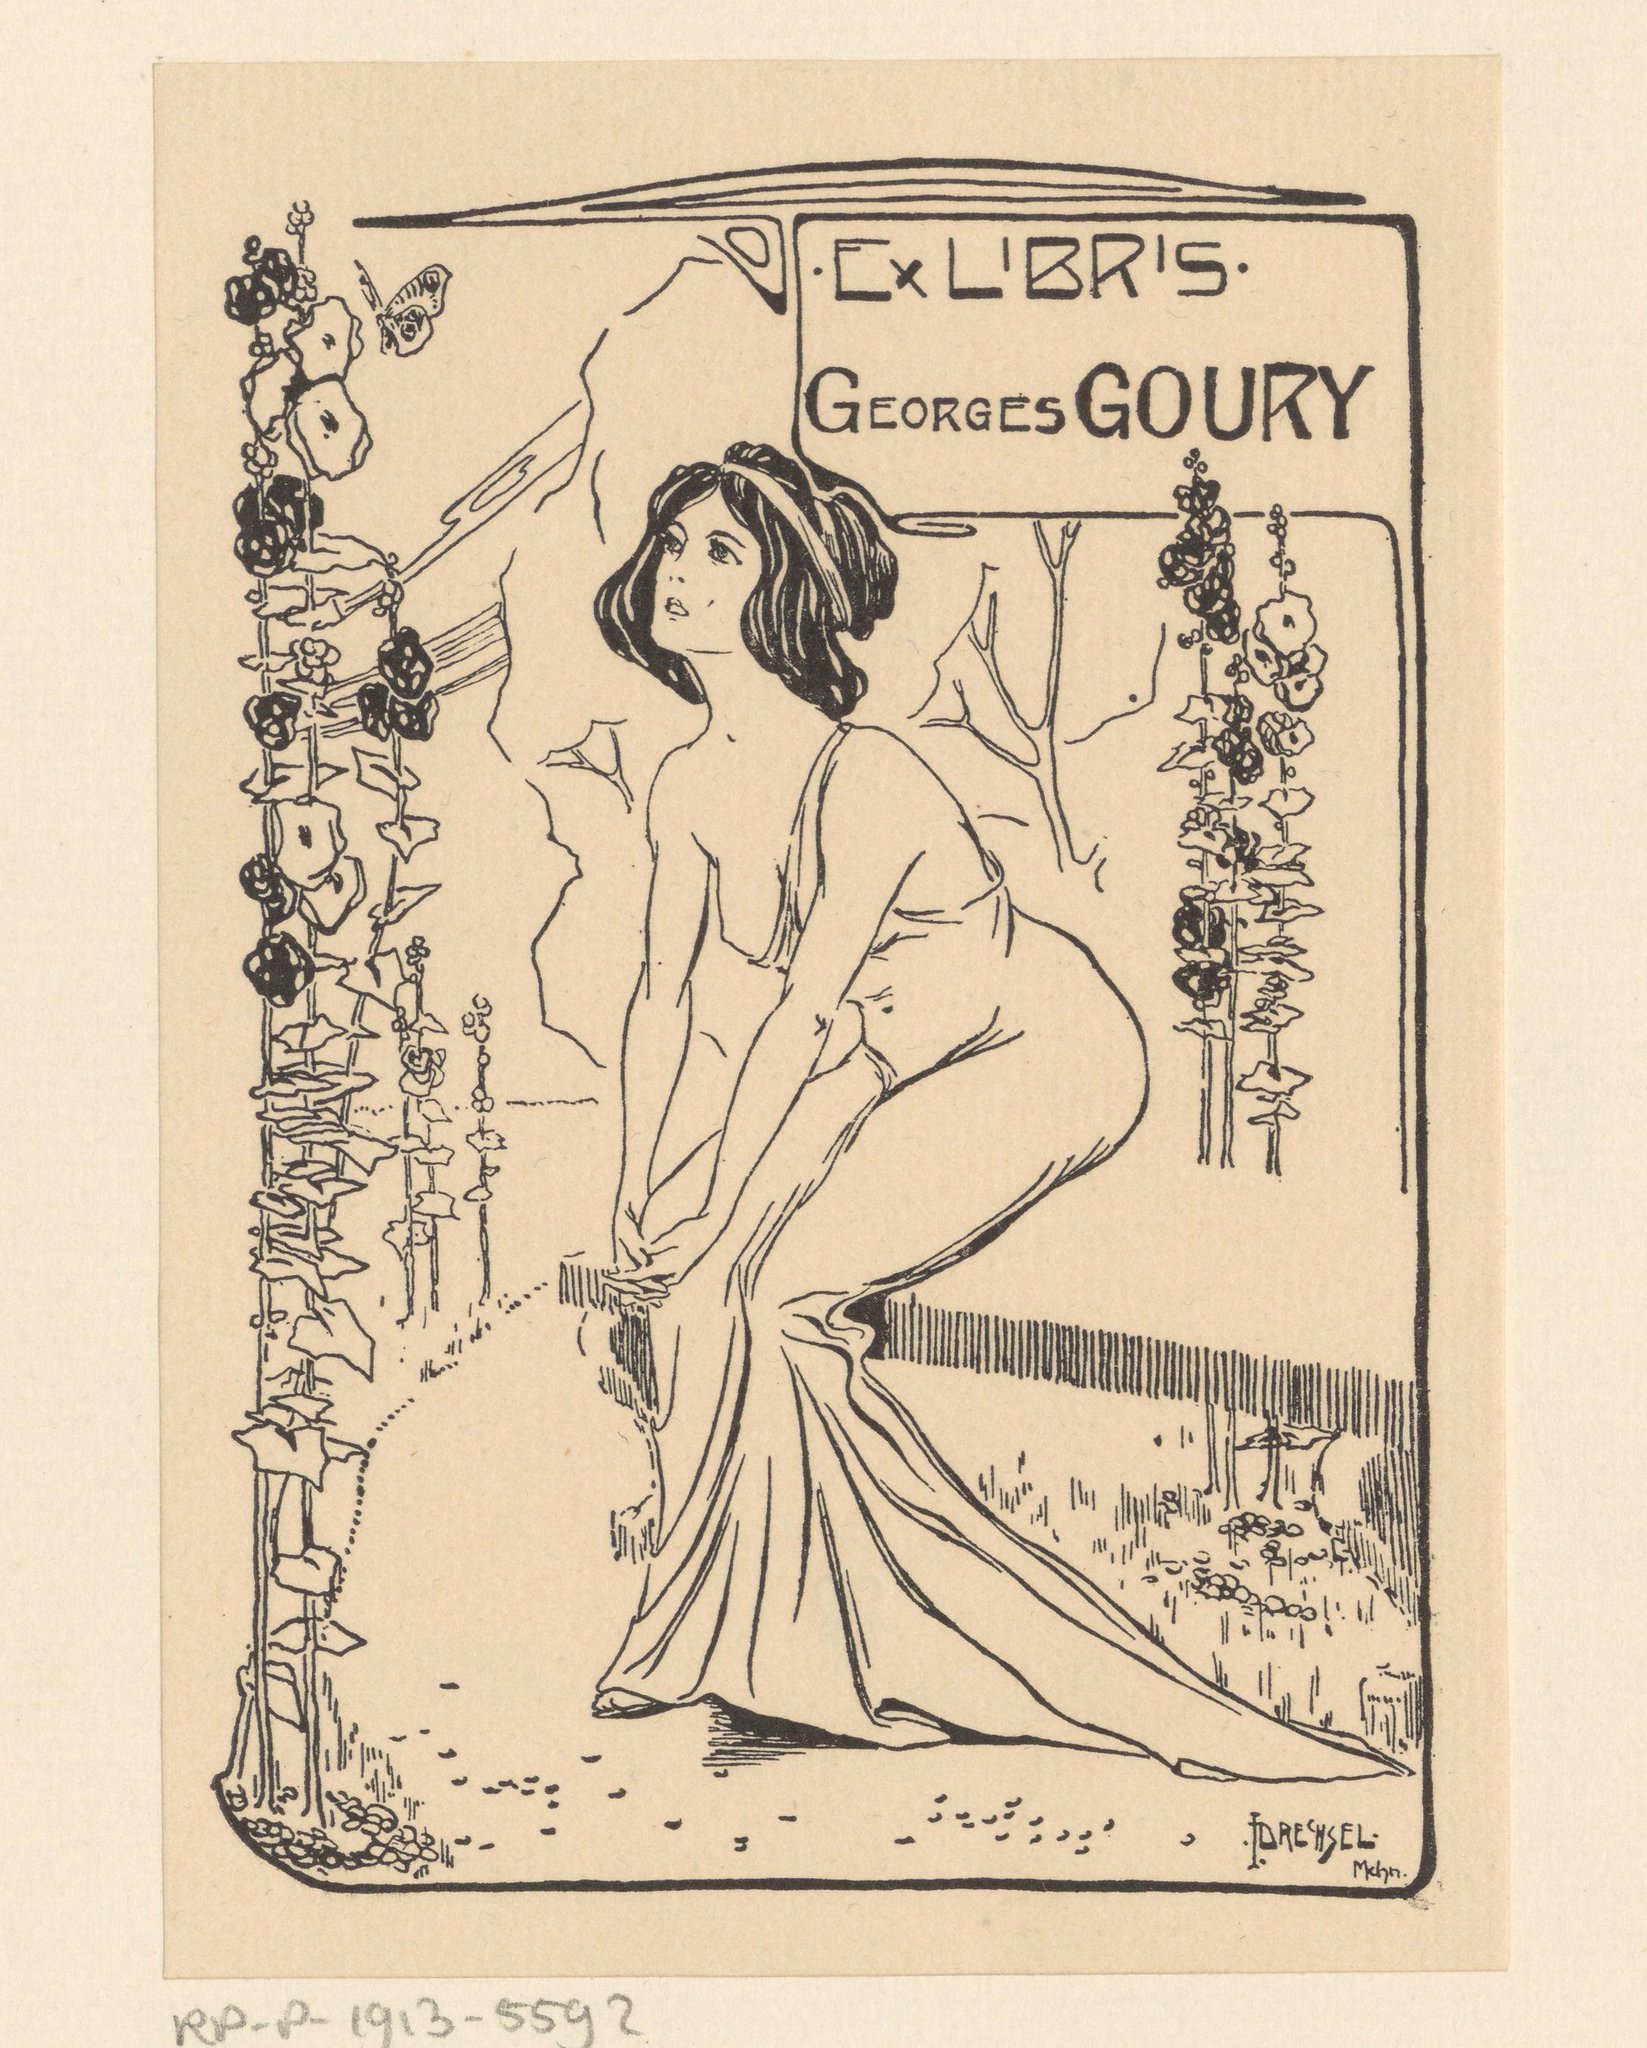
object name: bookplate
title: Ex libris van Georges Goury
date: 1887-1913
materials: paper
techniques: printing block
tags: flowers, sitting figure - aa - female human figure, woman (showing herself) undressed, quasi-nude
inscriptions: collector's mark: Lugt 2760, collector's mark: Lugt 2233